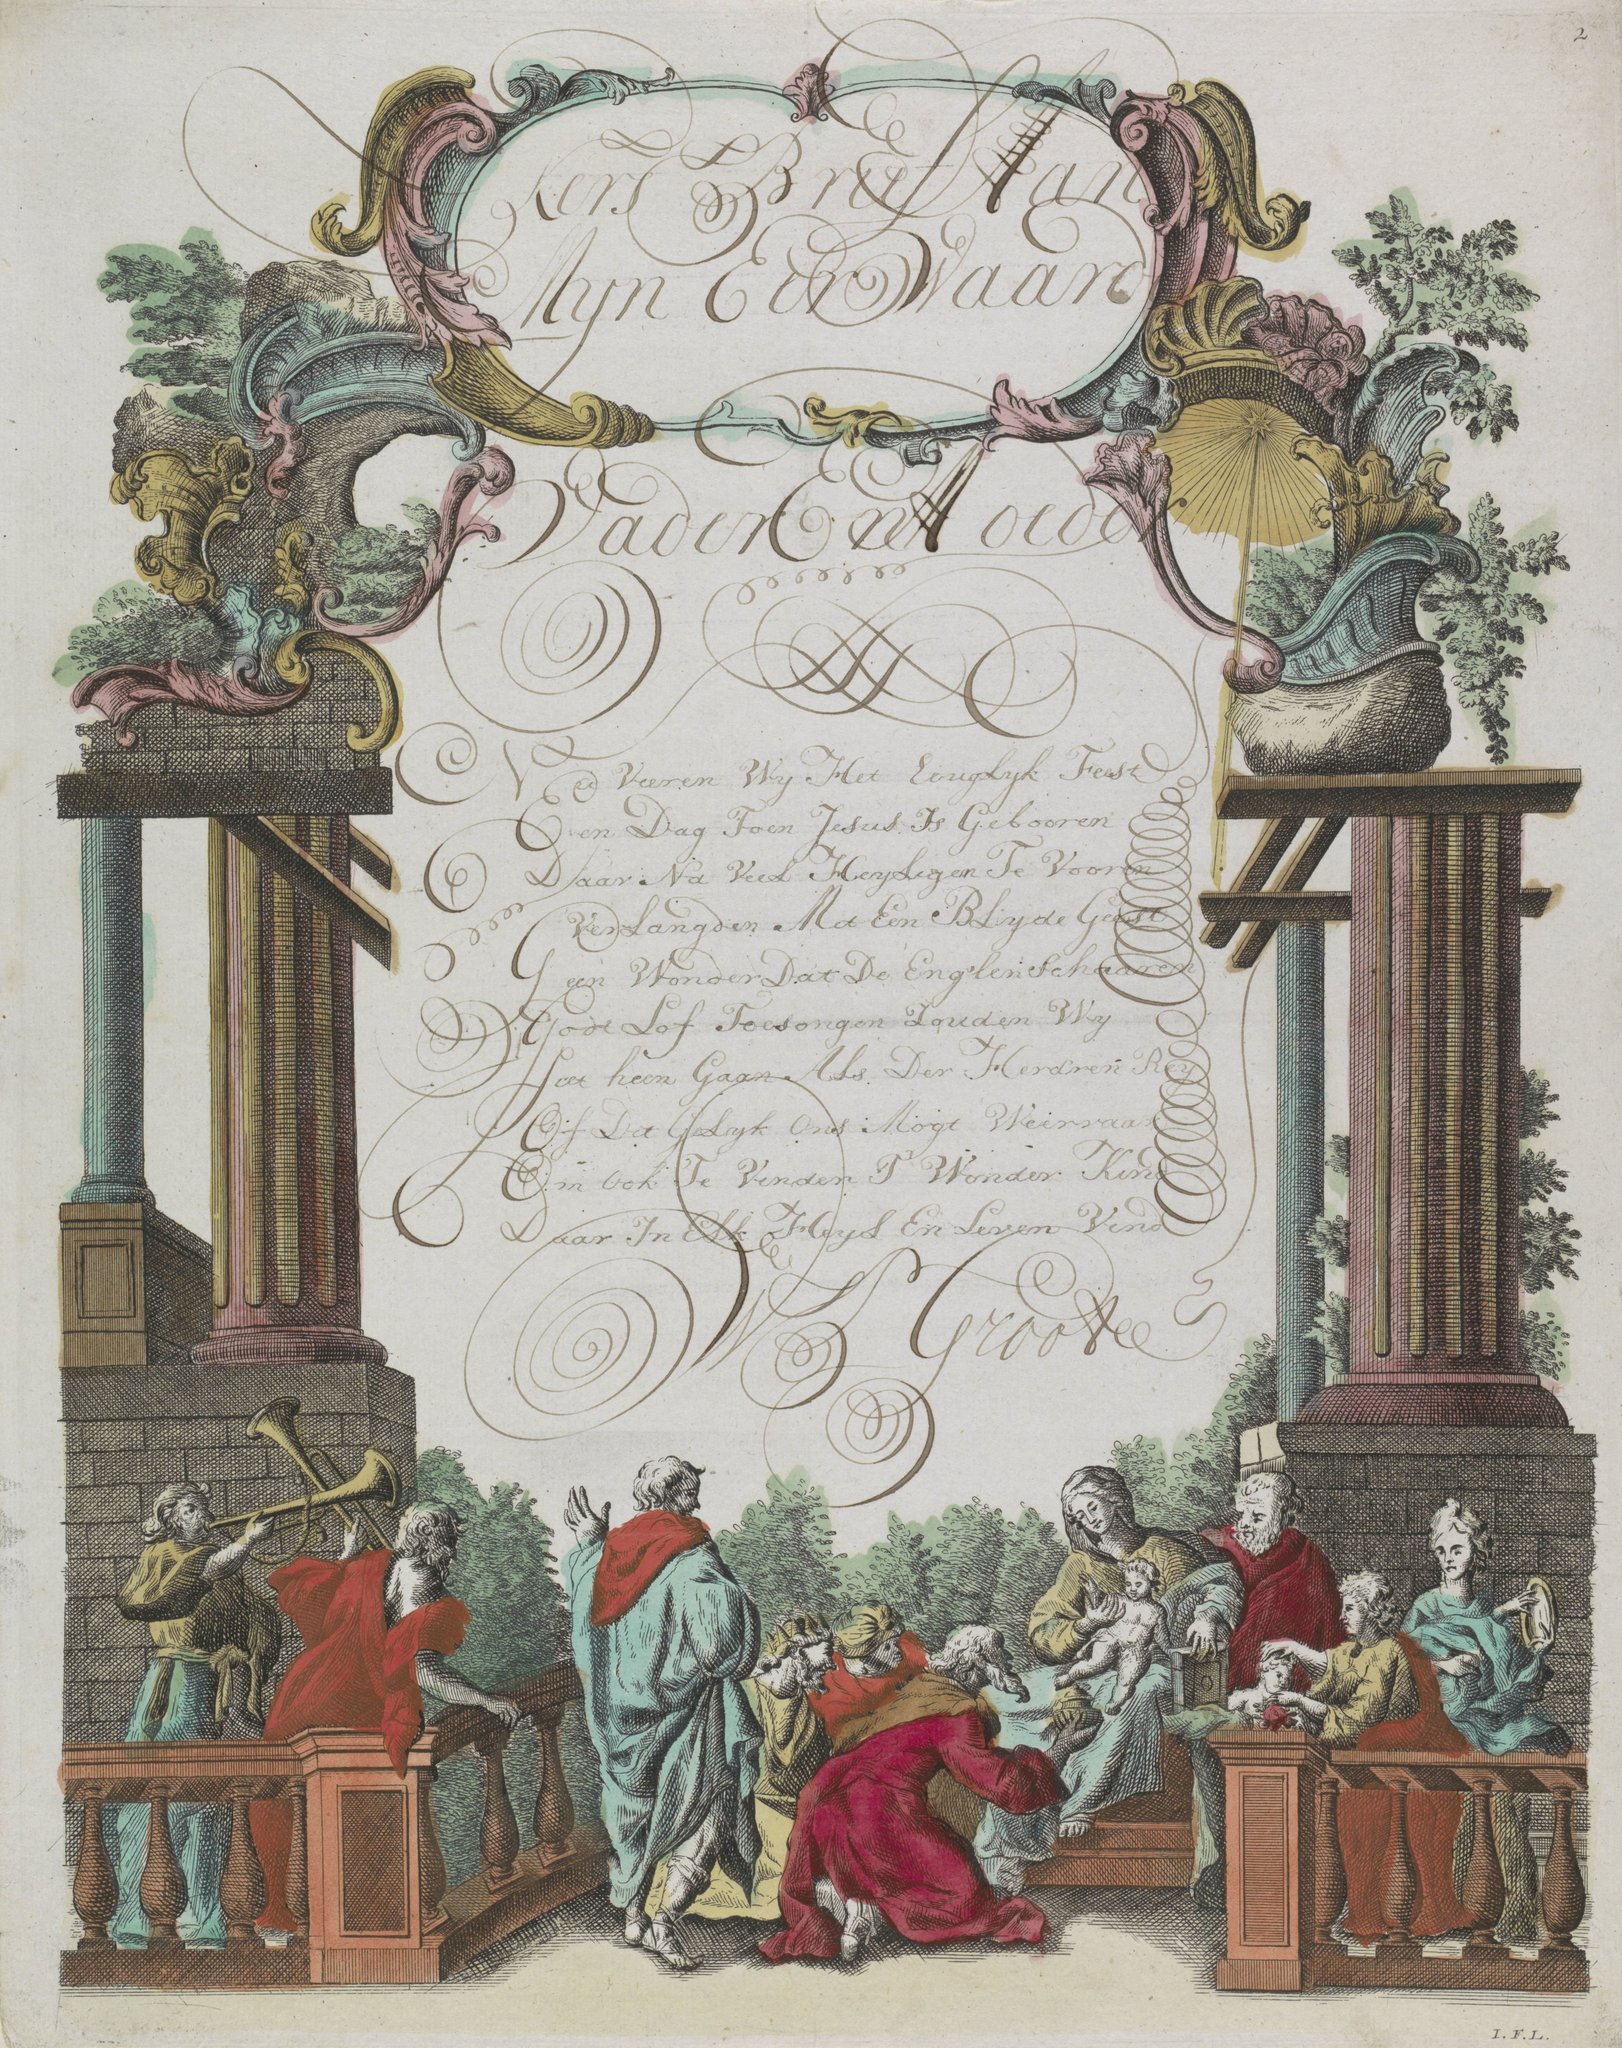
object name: wensbrief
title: Wensbrief met de aanbidding door de koningen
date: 1774-1775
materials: ink, paper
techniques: calligraphy, colour, etching, pen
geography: netherlands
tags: adoration of the kings: the wise men present their gifts to the christ-child (gold, frankincense and myrrh)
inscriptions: inscription: ‘Kers brief aan mijn eerwaard vader en moeder / Nu vieren wy het heuglijk feest [...]’, collector's mark: Lugt 2760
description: Wensbrief met beschreven cartouche binnen een decoratief kader met een voorstelling van de aanbidding door de koningen. Handgeschreven bericht in kalligrafie (Kerstbrief) door W. Groot aan zijn vader en moeder.